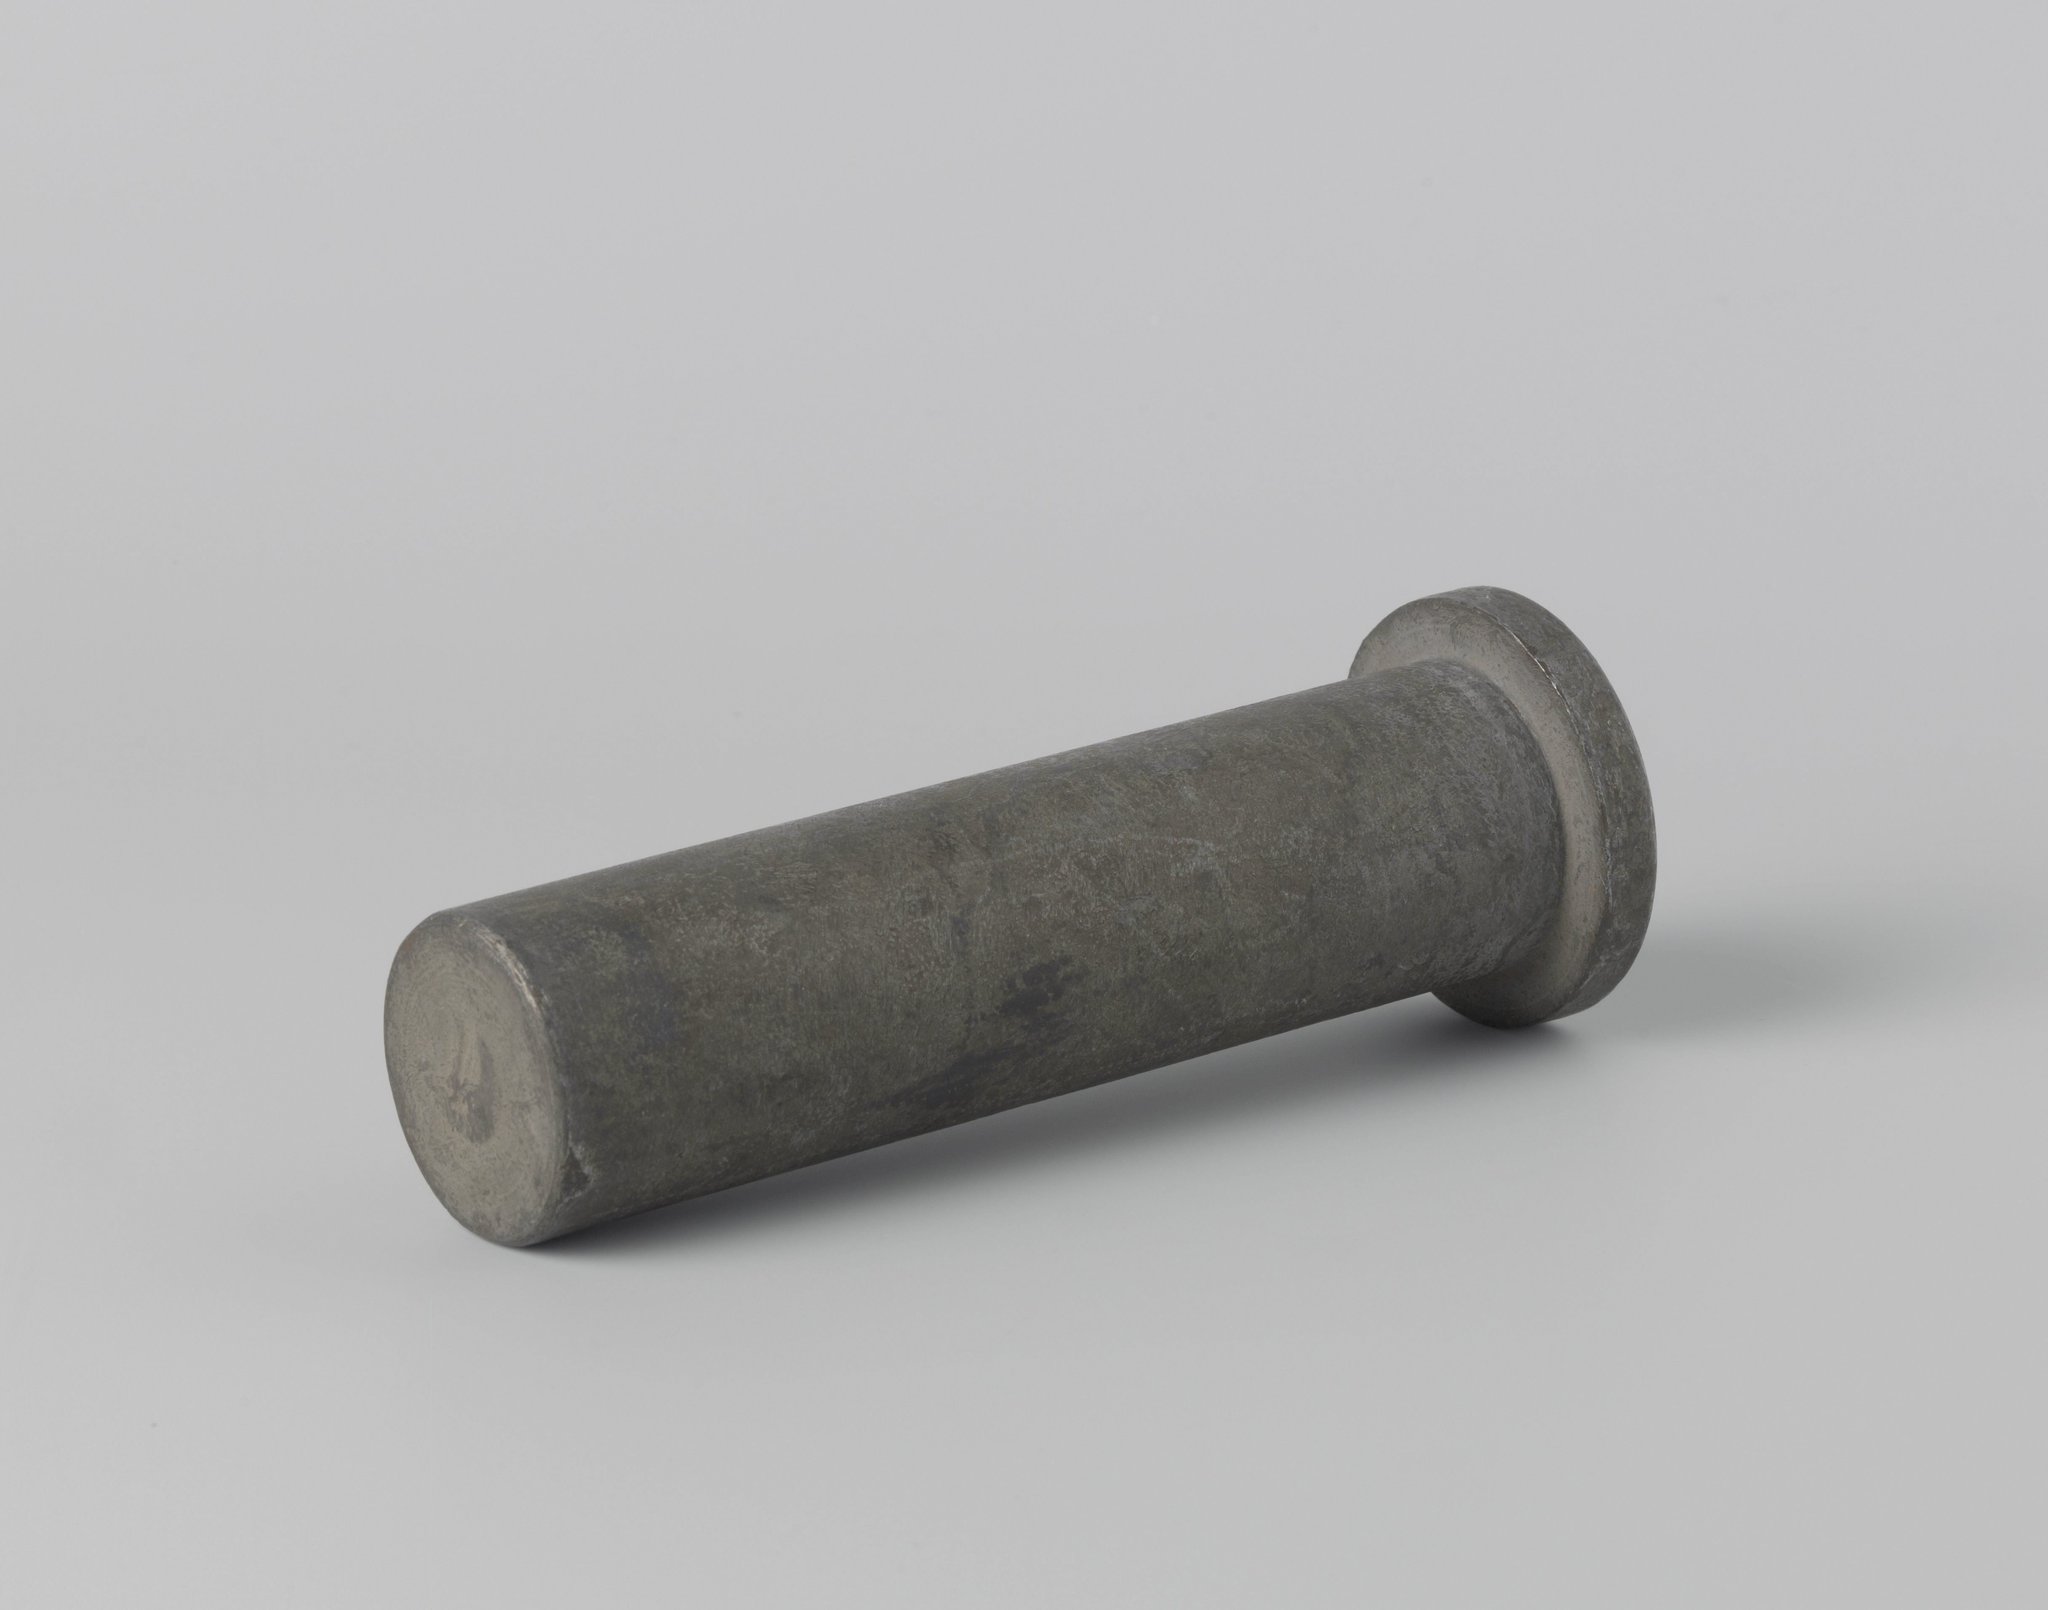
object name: pin fastener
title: Pen om een kanon vast te maken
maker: Anonymous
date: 1850-1900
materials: iron